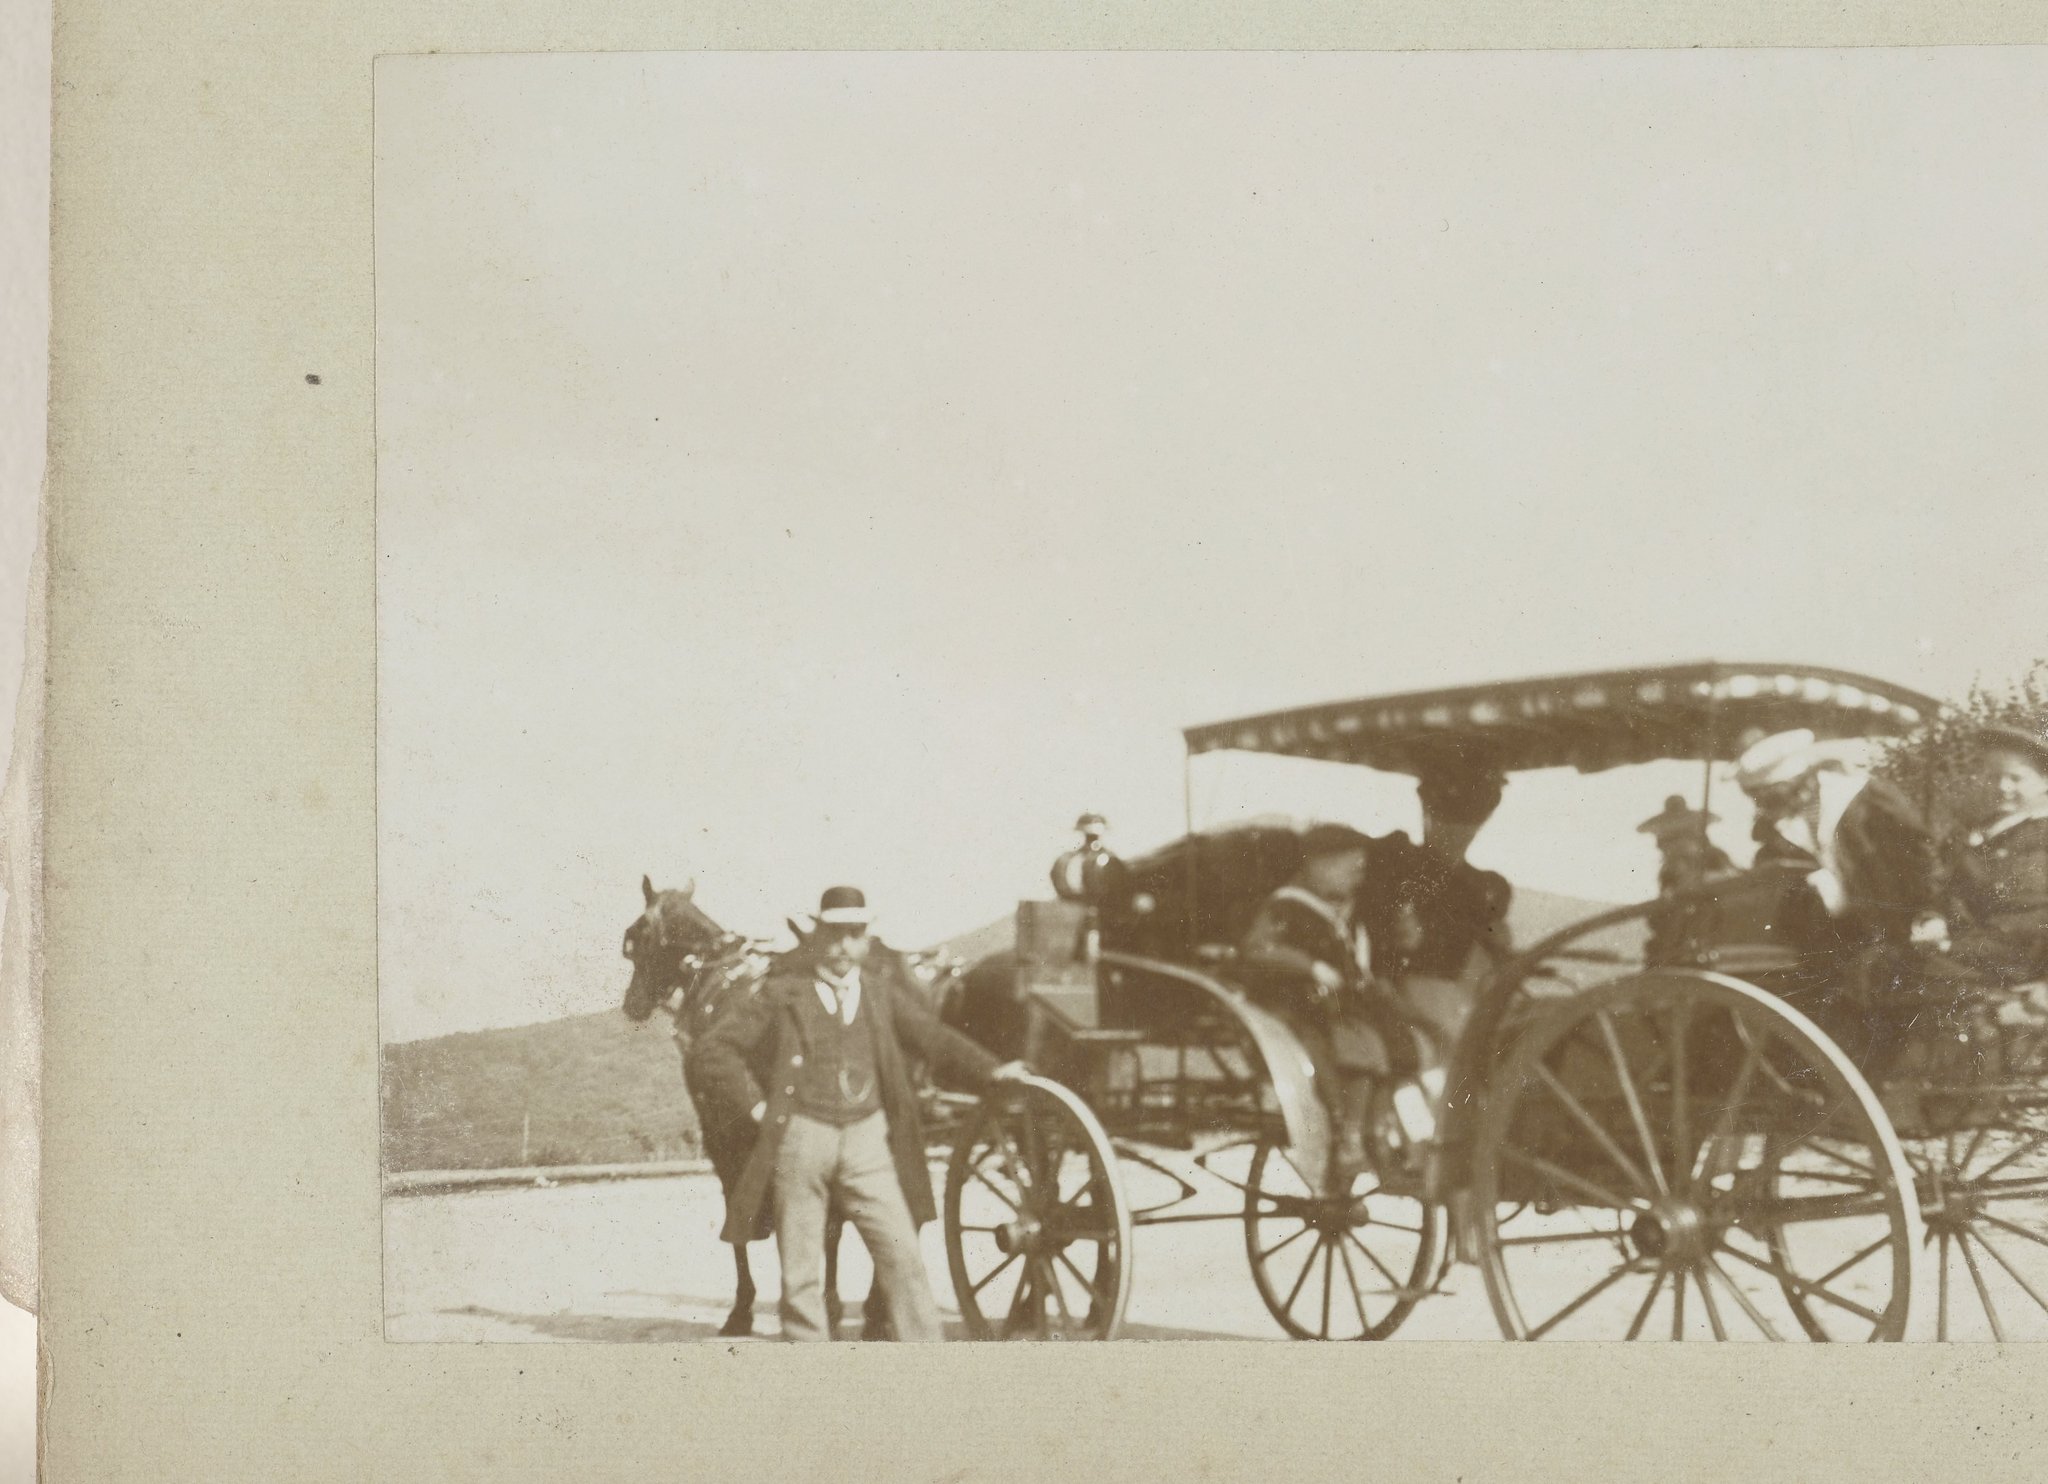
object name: album leaf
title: Familie Vermeulen in een rijtuig, Königswinter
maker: david vermeulen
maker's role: fotograaf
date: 1895-1905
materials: paper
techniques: collodion silver print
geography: königswinter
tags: four-wheeled vehicle drawn by one animal